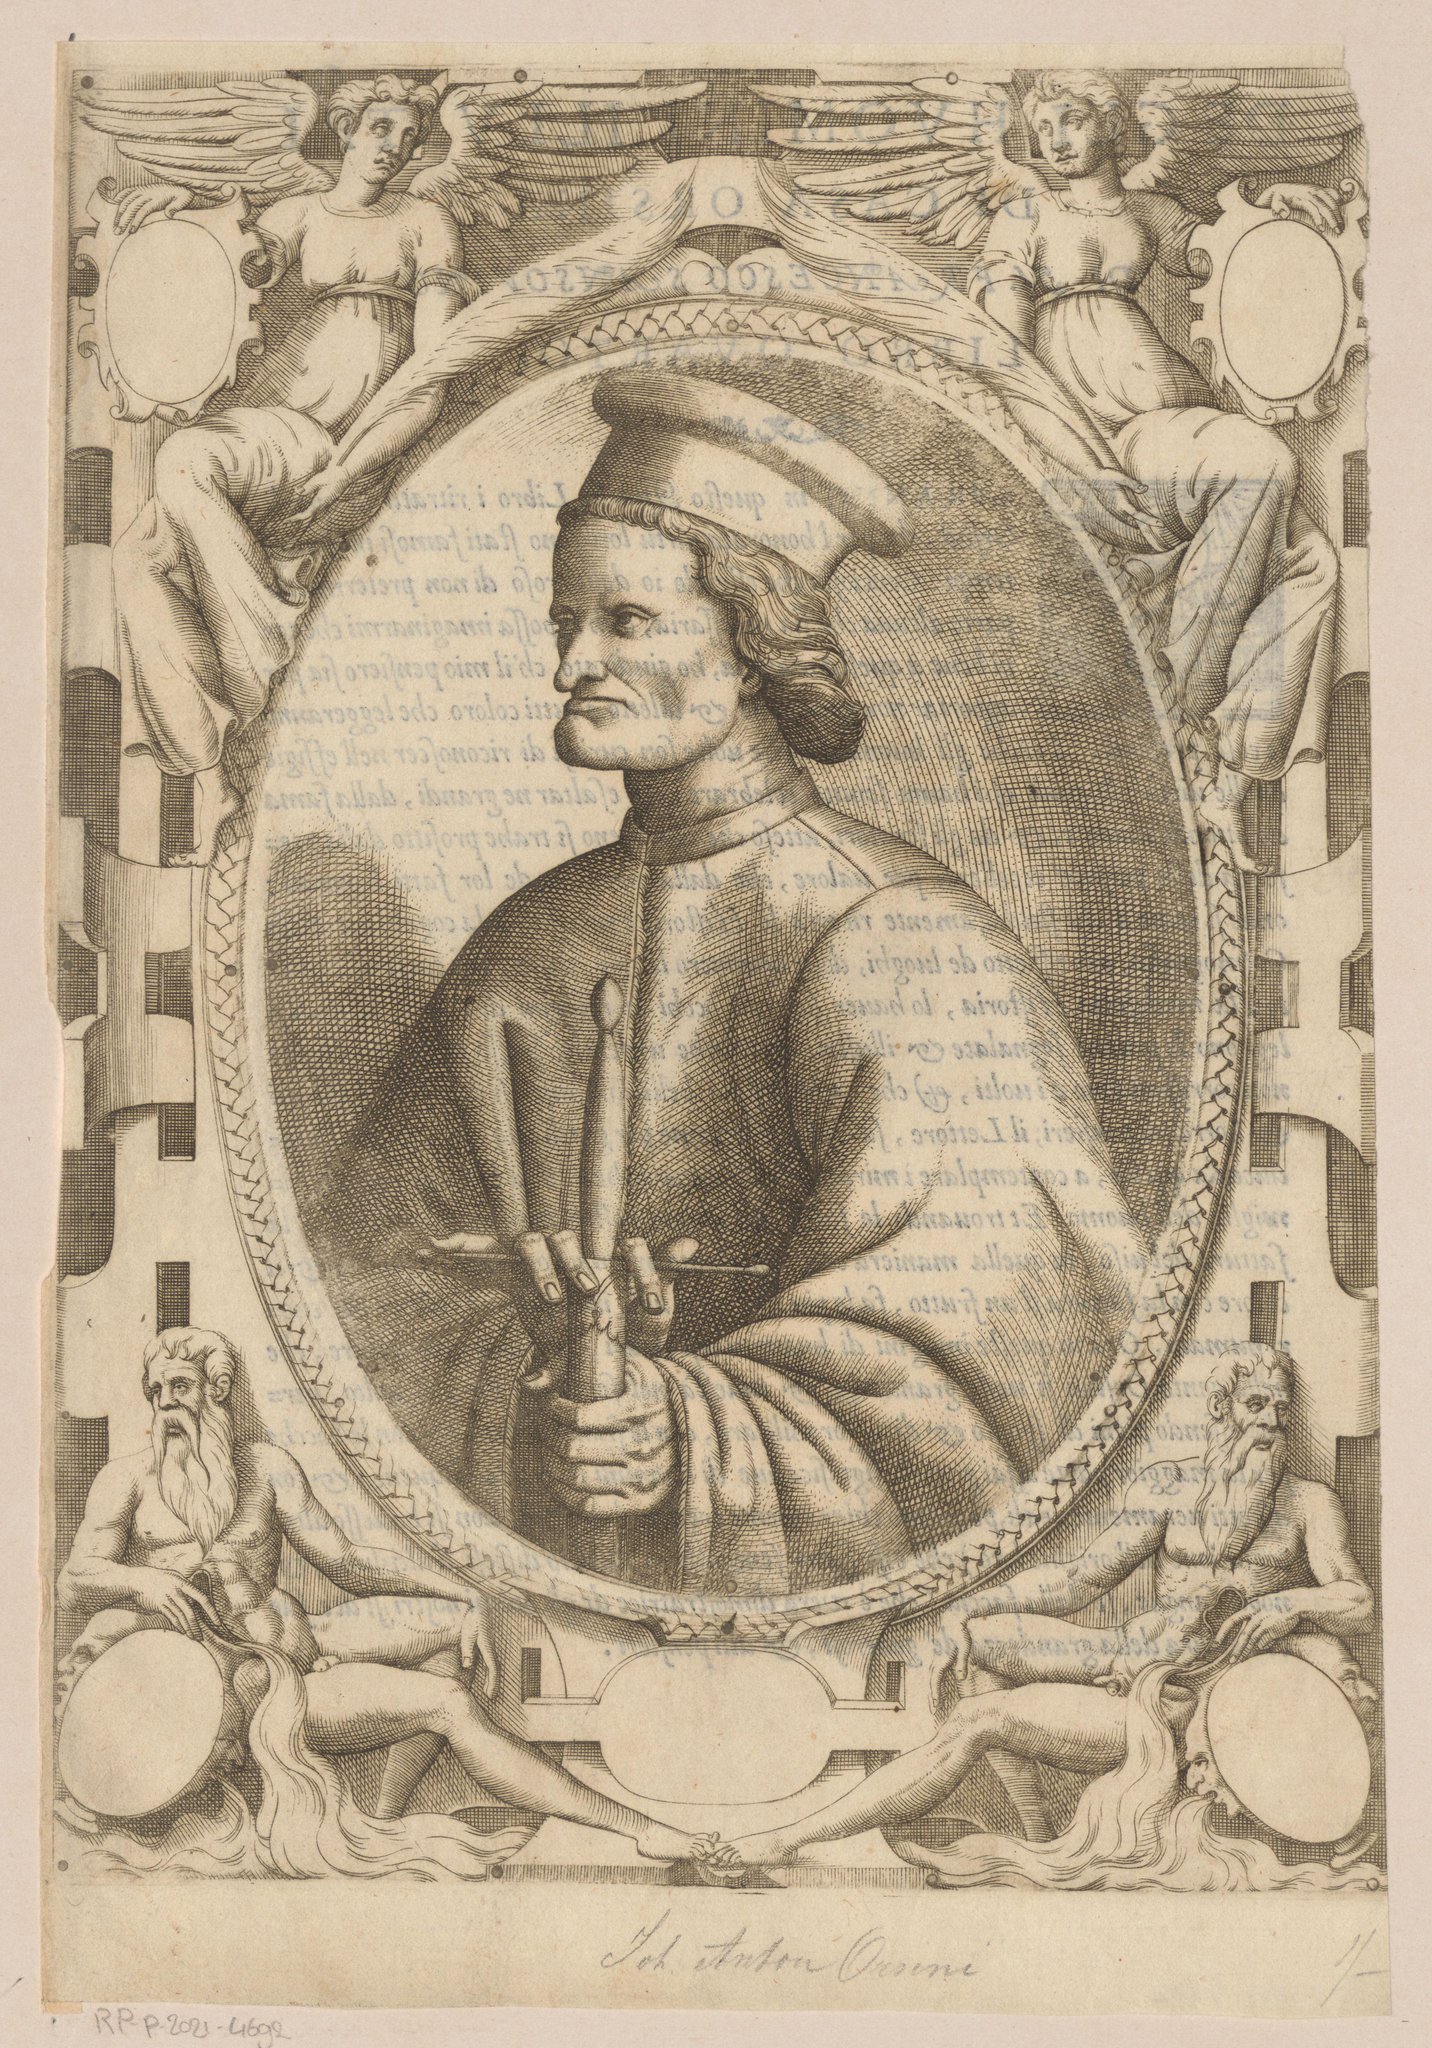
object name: print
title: Portret van Giovanni Antonio Orsini del Balzo, prins van Taranto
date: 1565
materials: paper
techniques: engraving, letterpress printing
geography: venice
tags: altamura, historical persons, river-gods, angels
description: Prent uit: Sansovino, Francesco. L'Historia di Casa Orsina di Francesco Sansovino. Venetië: Filippo en Bernardino Stagnino, 1565.